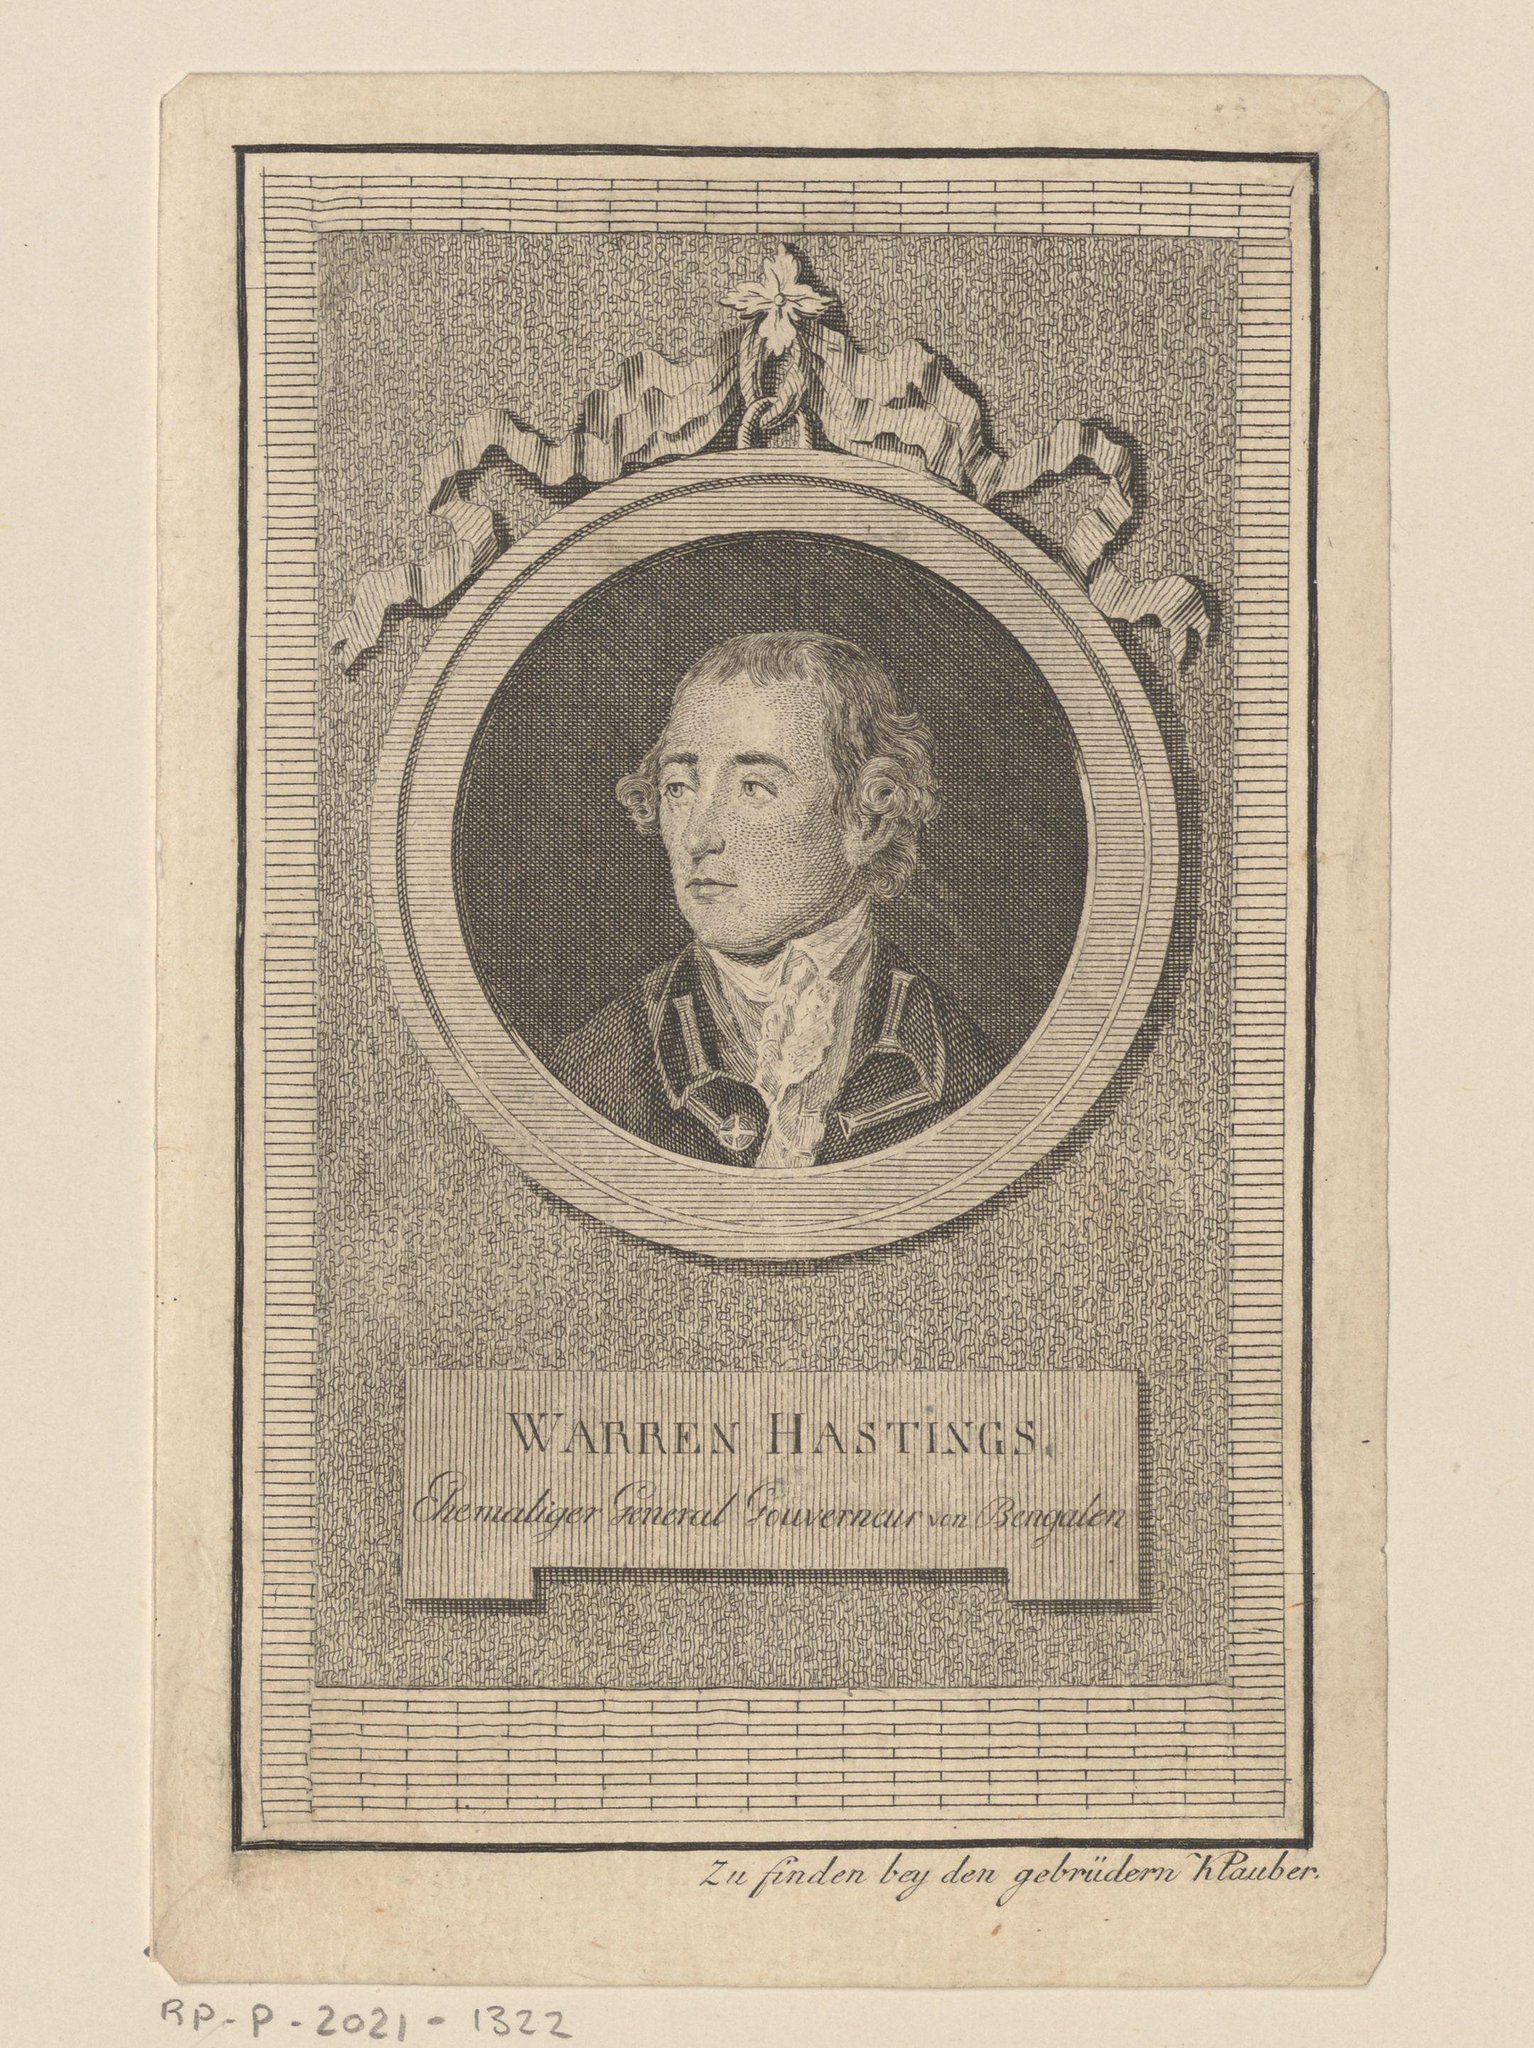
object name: print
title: Portret van Warren Hastings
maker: Anonymous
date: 1772-1799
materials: paper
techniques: engraving, etching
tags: colonial governor, historical persons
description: Andere staat van de prent gebruikt in: Historisches Portefeuille. S.l.s.n. 1787, dl. 4.